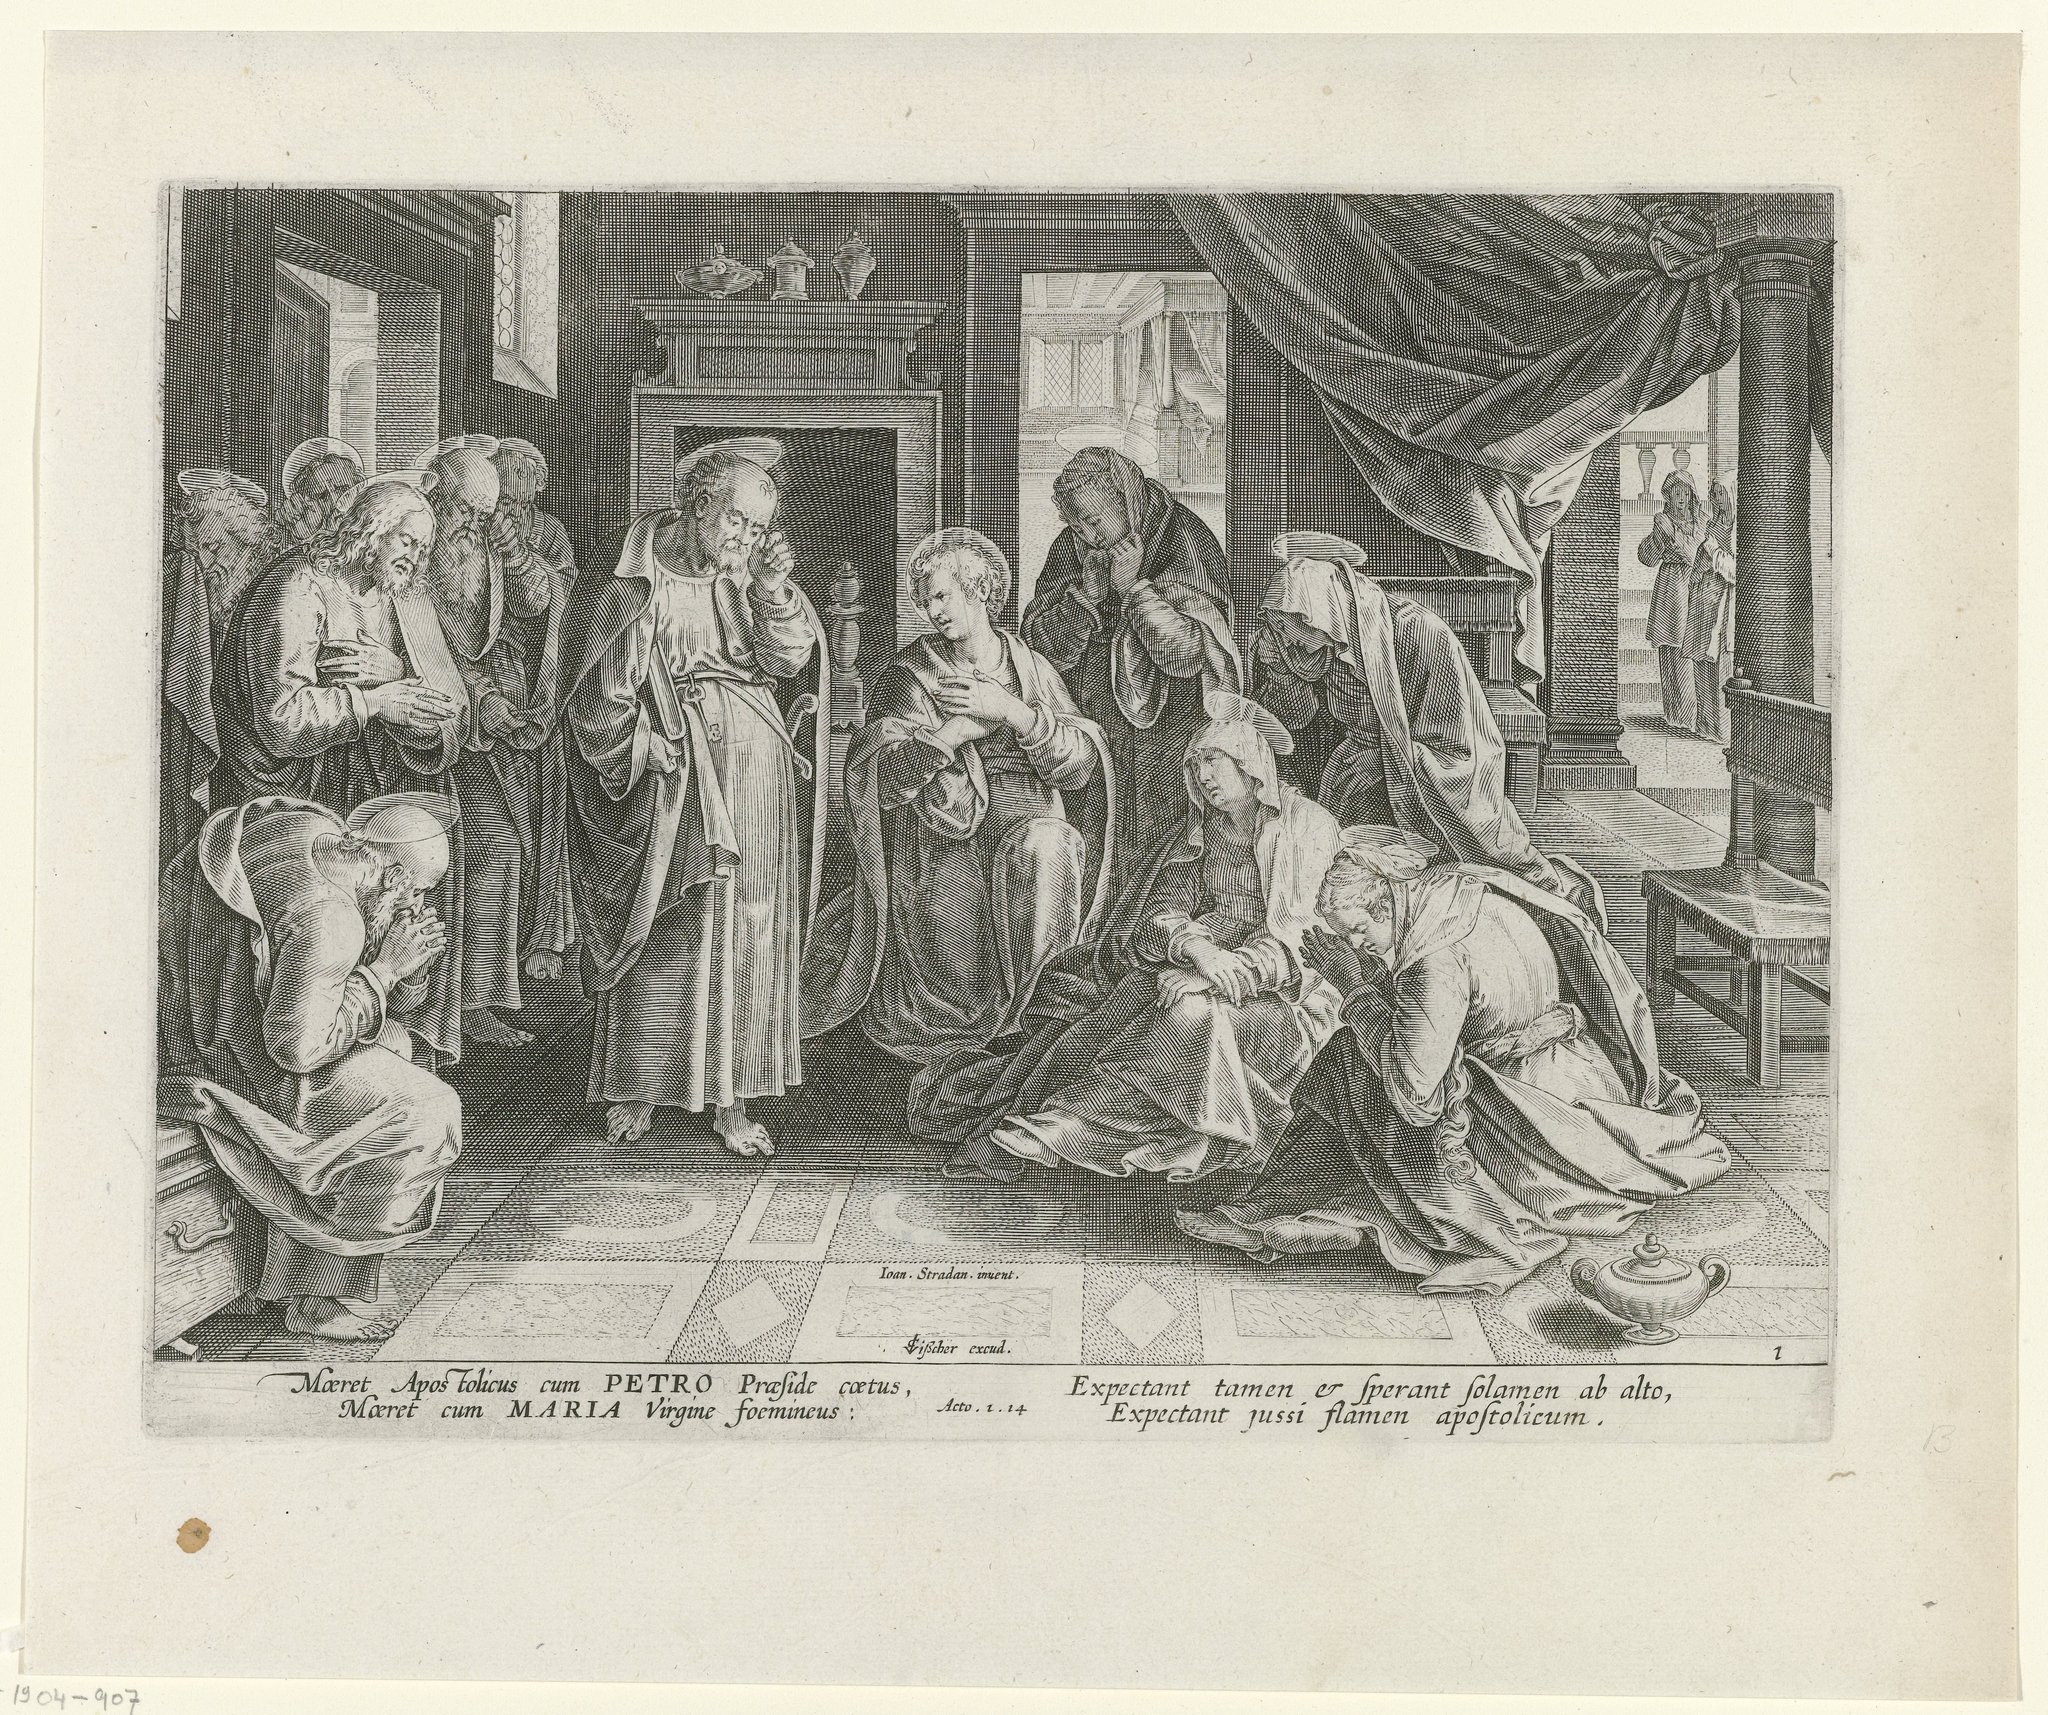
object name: print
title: Maria en de apostelen rouwen om Christus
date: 1547-1612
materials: paper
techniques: engraving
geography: antwerp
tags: disciples awaiting the return of christ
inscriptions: collector's mark: Lugt 2228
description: Centraal in een woonkamer de apostelen, Maria en enkele vrouwen. Ze huilen en rouwen om de dood van Christus. De prent heeft een Latijns onderschrift.